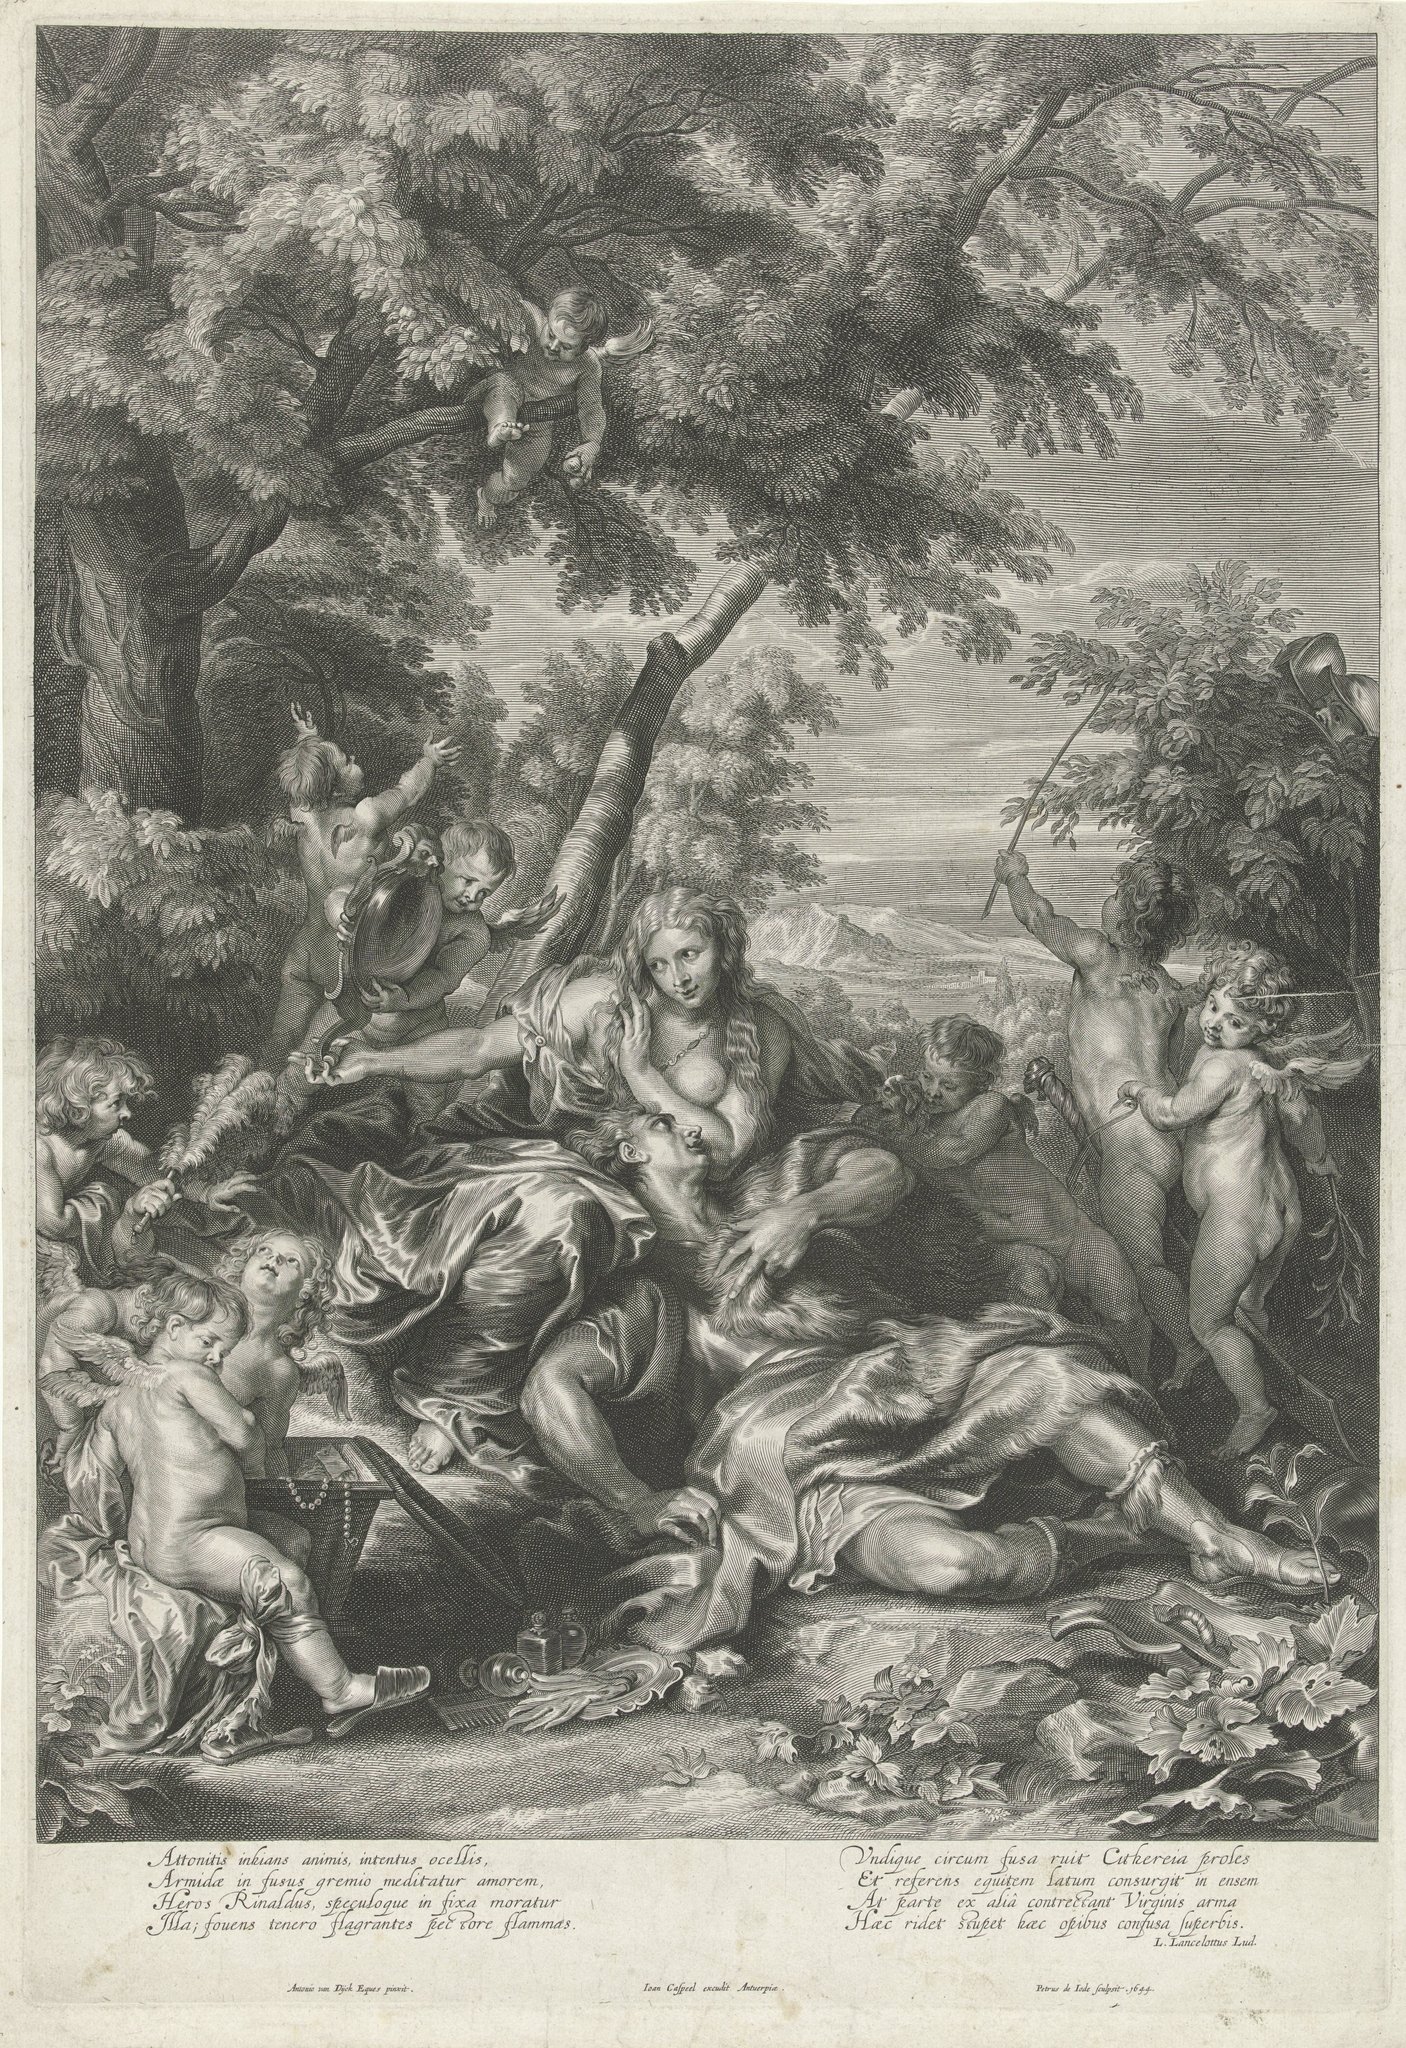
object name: print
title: Rinaldo en Armida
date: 1644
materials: paper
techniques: engraving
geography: antwerp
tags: rinaldo, armida, (scenes from) specific works of literature: tasso, gerusalemme liberata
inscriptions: collector's mark: Lugt 240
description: Rinaldo rust in de schoot van de jonge Armida. Hij kijkt in haar ogen naar zijn eigen spiegelbeeld. Zij kijkt in een spiegel die door een putto omhoog gehouden wordt. Zo aanschouwen zij beiden hun eigen verliefde aanblik. De twee ridders die op zoek waren naar Rinaldo kijken toe vanuit de struiken. In de marge een achtregelig onderschrift, in twee kolommen, in het Latijn.